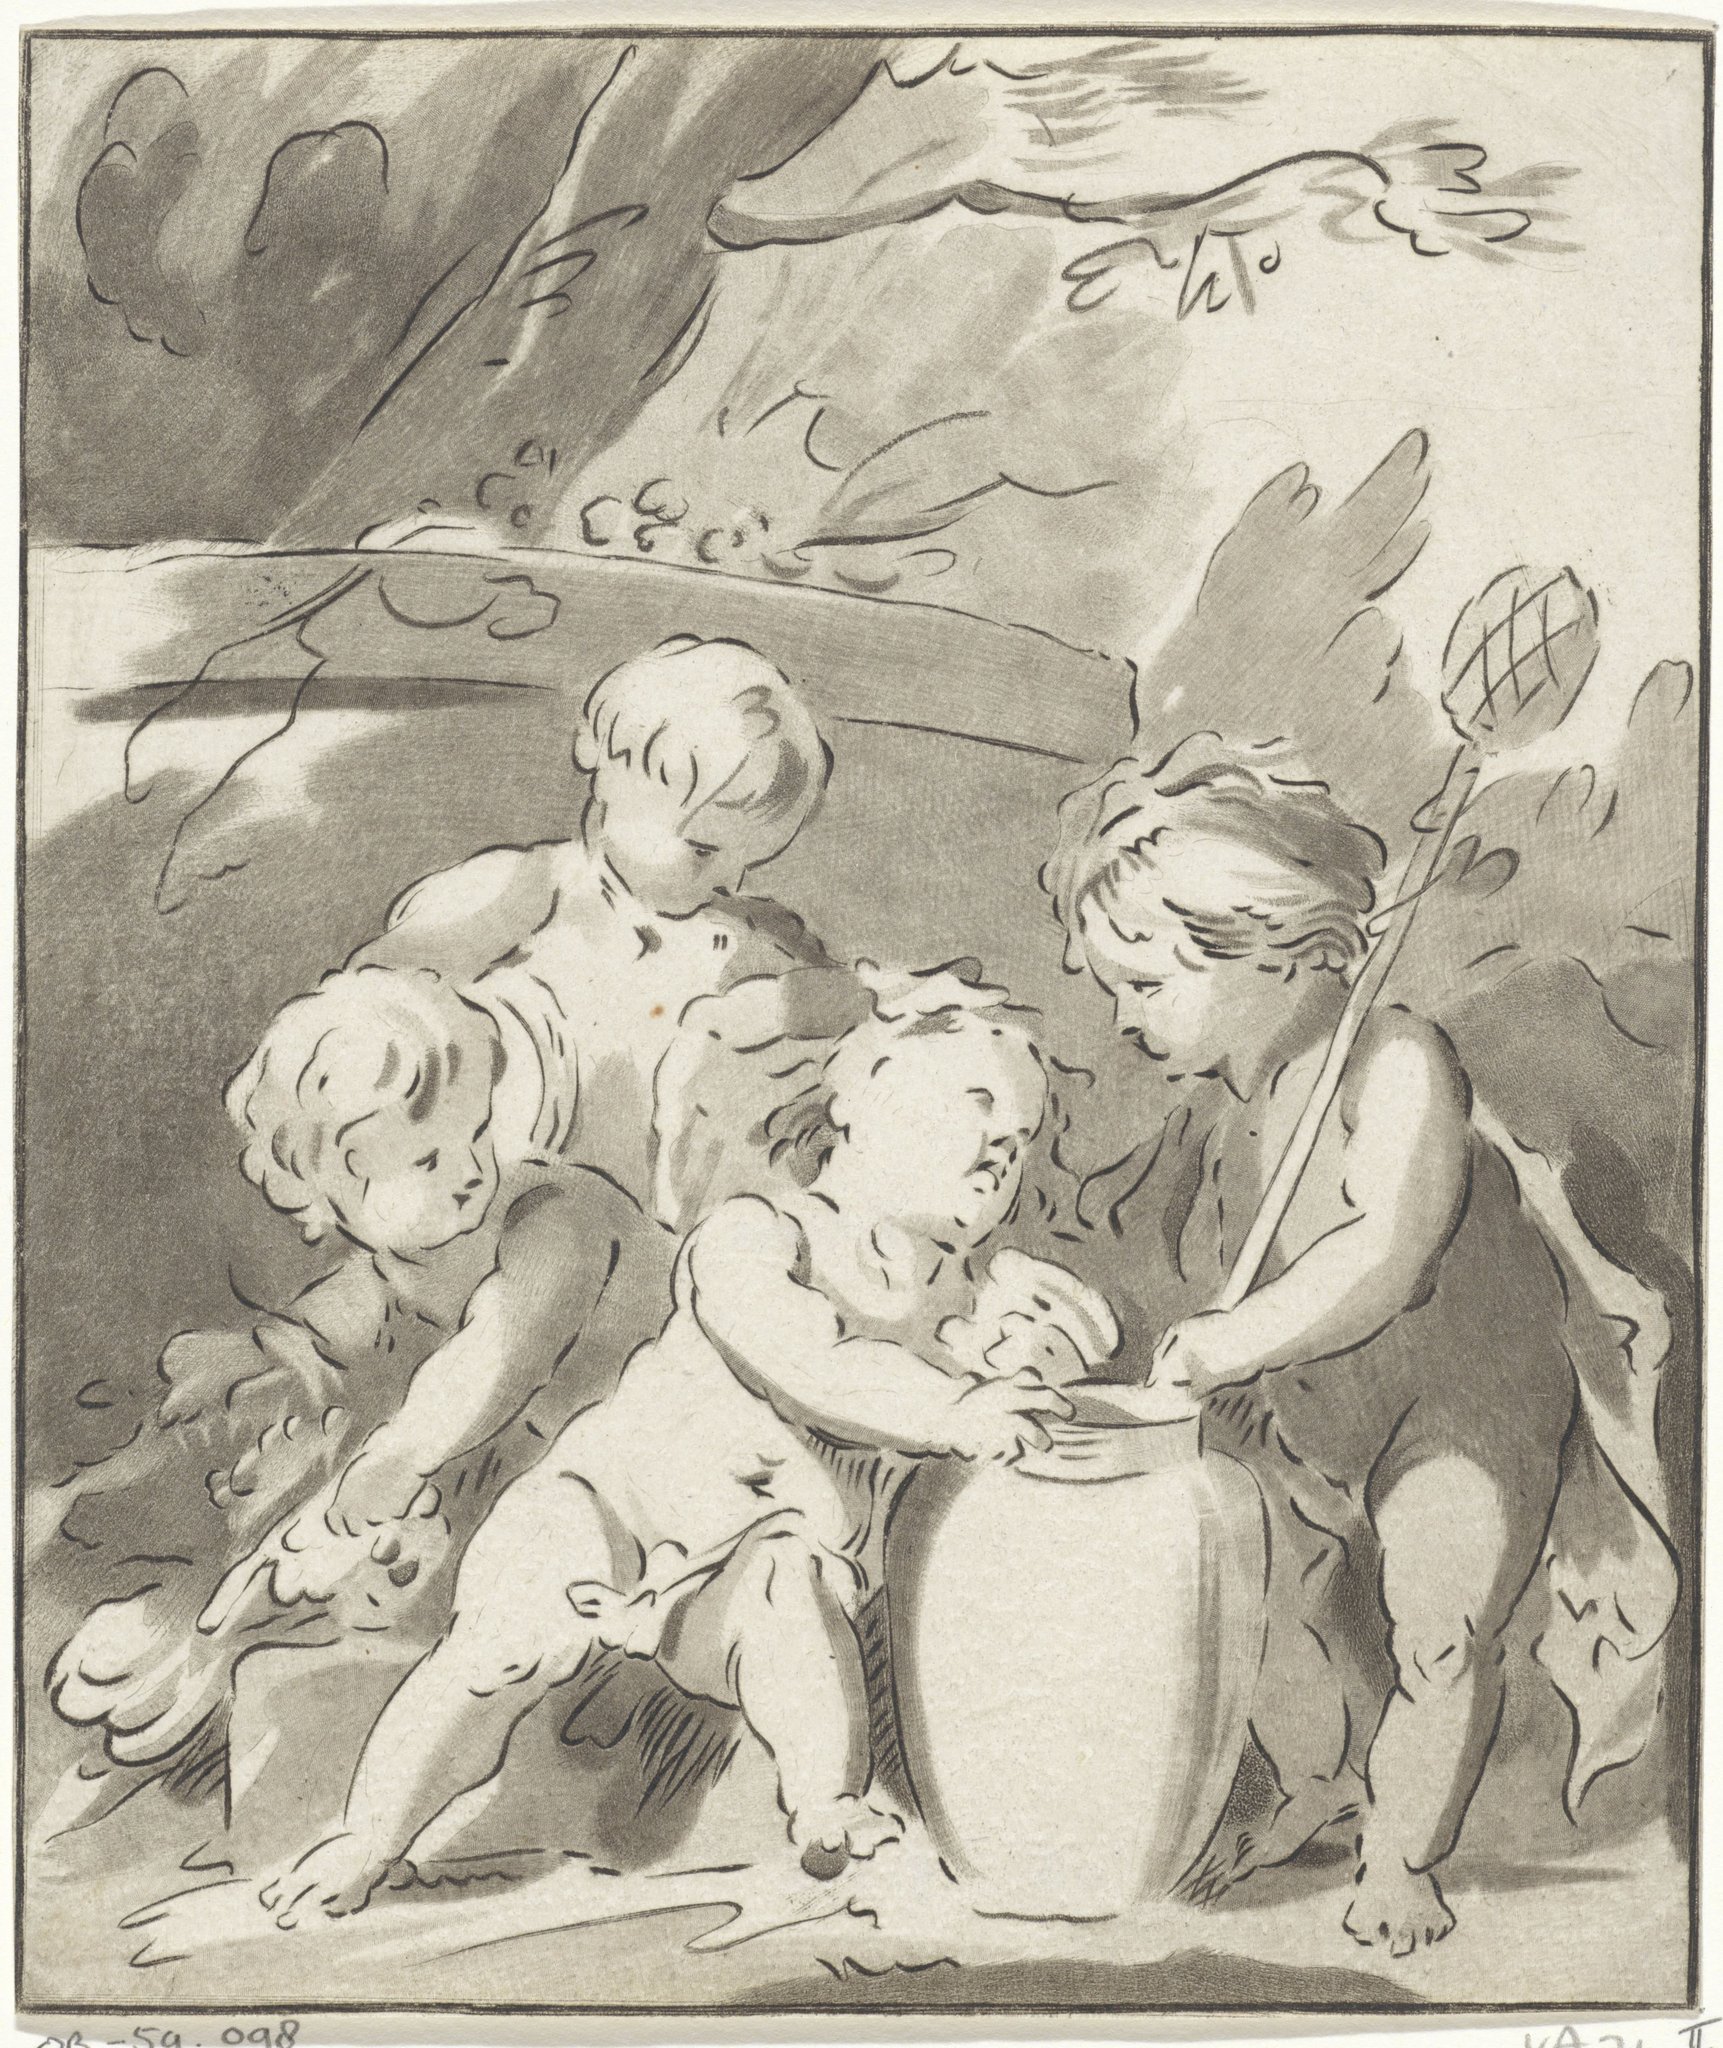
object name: print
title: Vier putti bij een vaas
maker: bernhard schreuder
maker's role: print maker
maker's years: -1780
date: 1767-1780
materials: paper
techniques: etching, rocker stamped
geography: netherlands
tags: cupids: 'amores', 'amoretti', 'putti', garden vase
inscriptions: collector's mark: Lugt 240